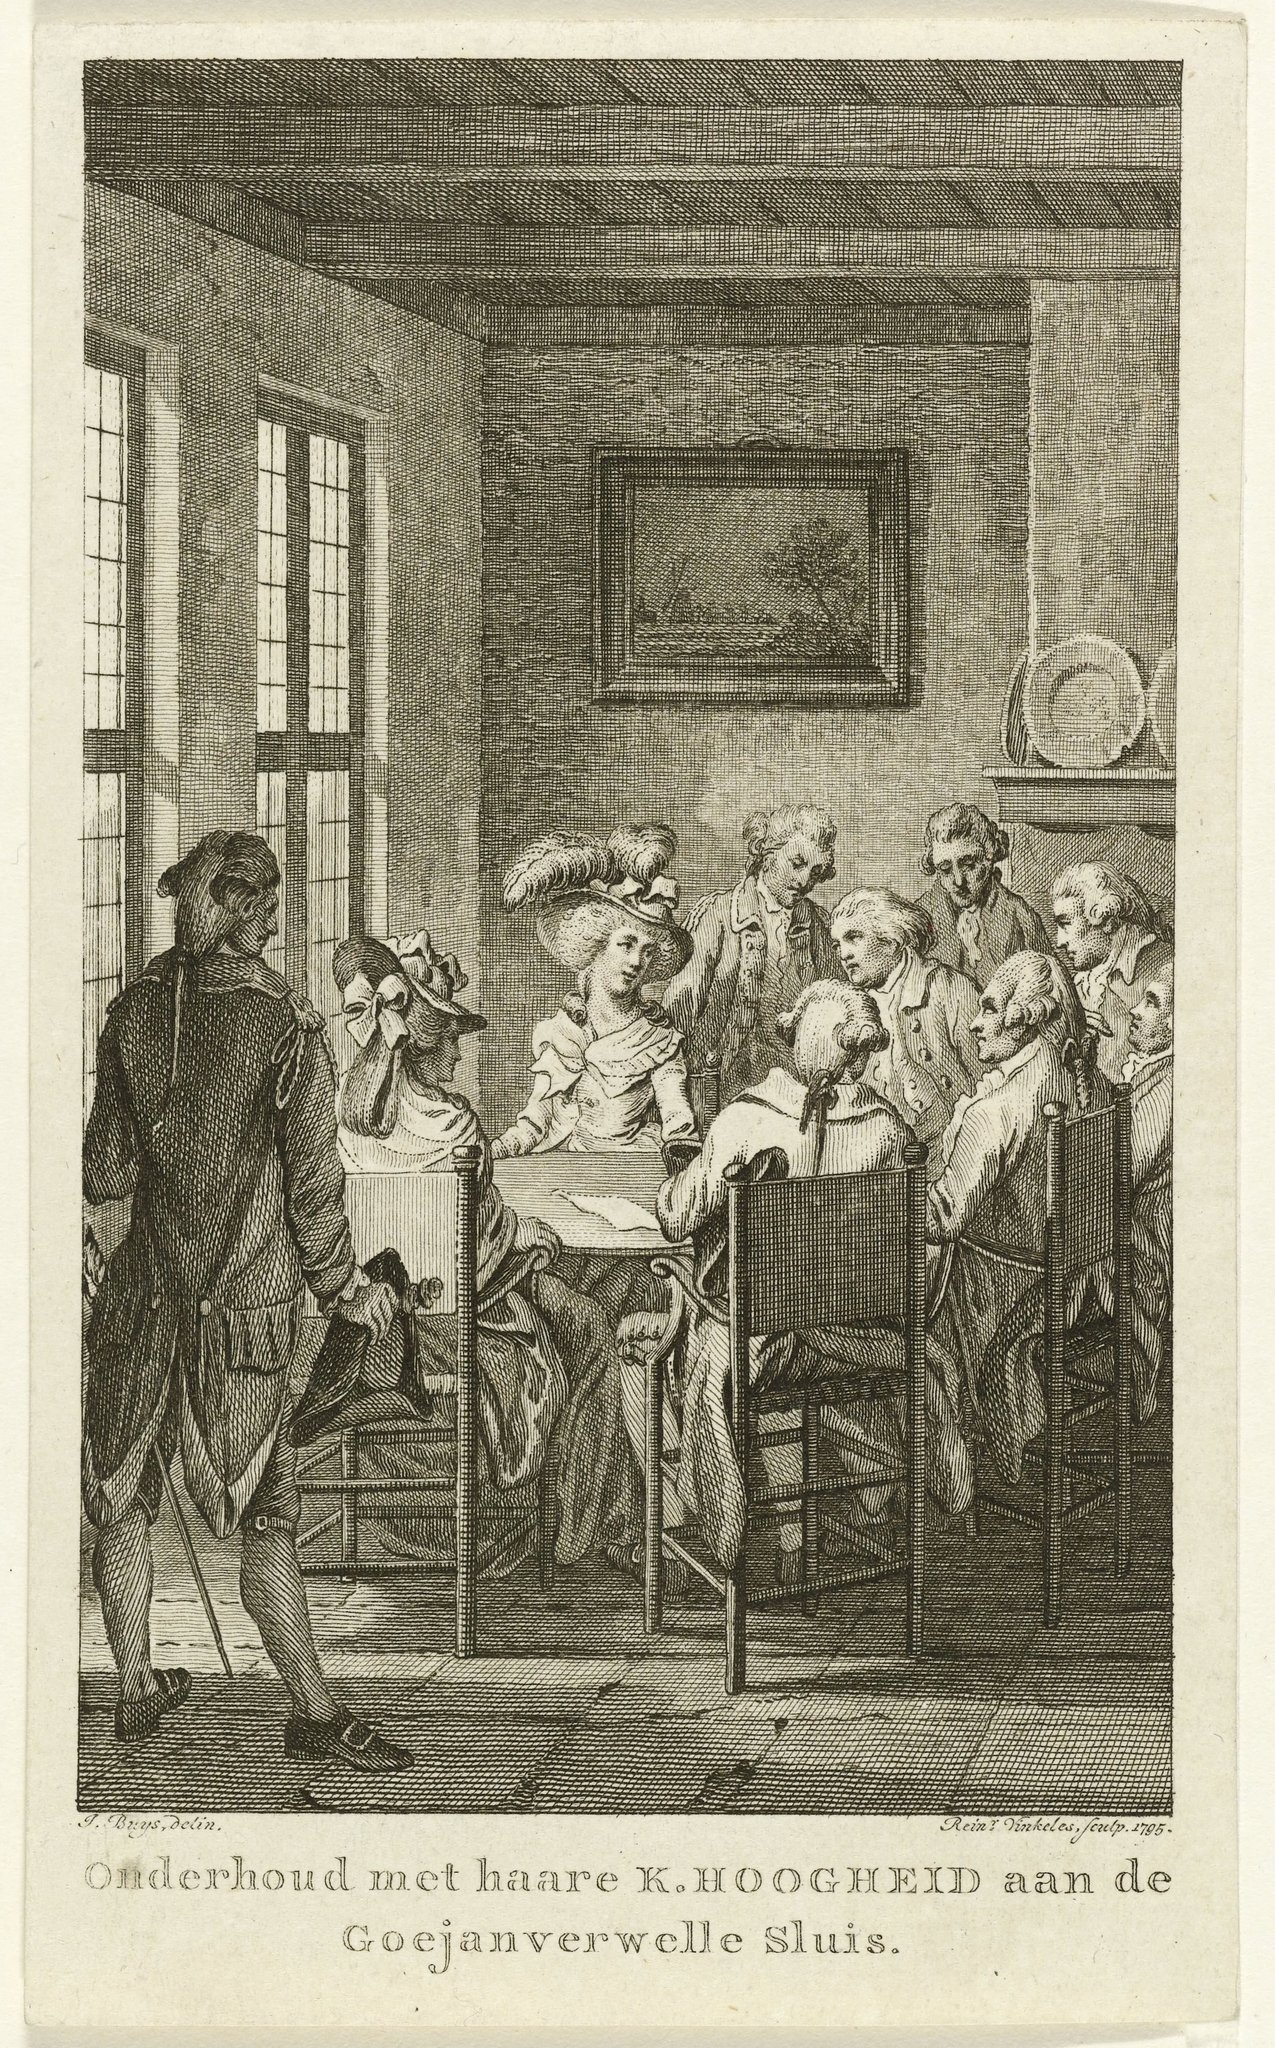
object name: print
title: Onderhoud met de prinses te Goejanverwellesluis, 1787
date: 1795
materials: paper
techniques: engraving, etching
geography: northern netherlands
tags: berlin, painter, draughtsman, wilhelmina of prussia (princess of orange), arrest (of criminal)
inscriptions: collector's mark: Lugt 2228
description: Gebruikt als illustratie in: P.A. Loosjes, Vaderlandsche historie, vervattende de geschiedenissen, der Vereenigde Nederlanden (...). Ten onmiddelyken vervolge van Wagenaar's Vaderlandsche historie.